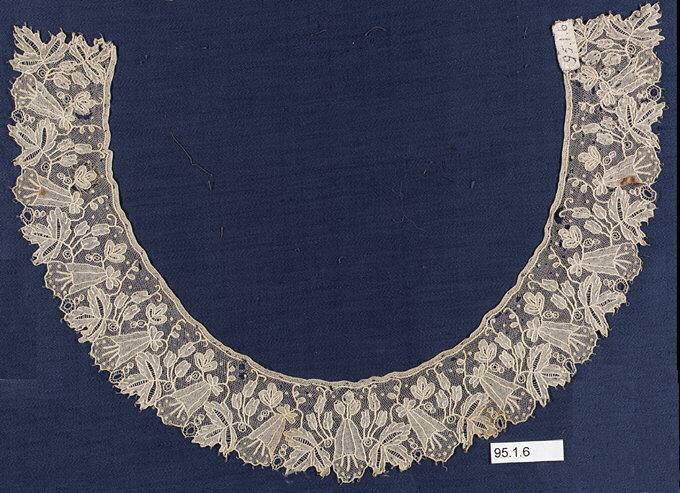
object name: collar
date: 1801-1833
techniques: lace